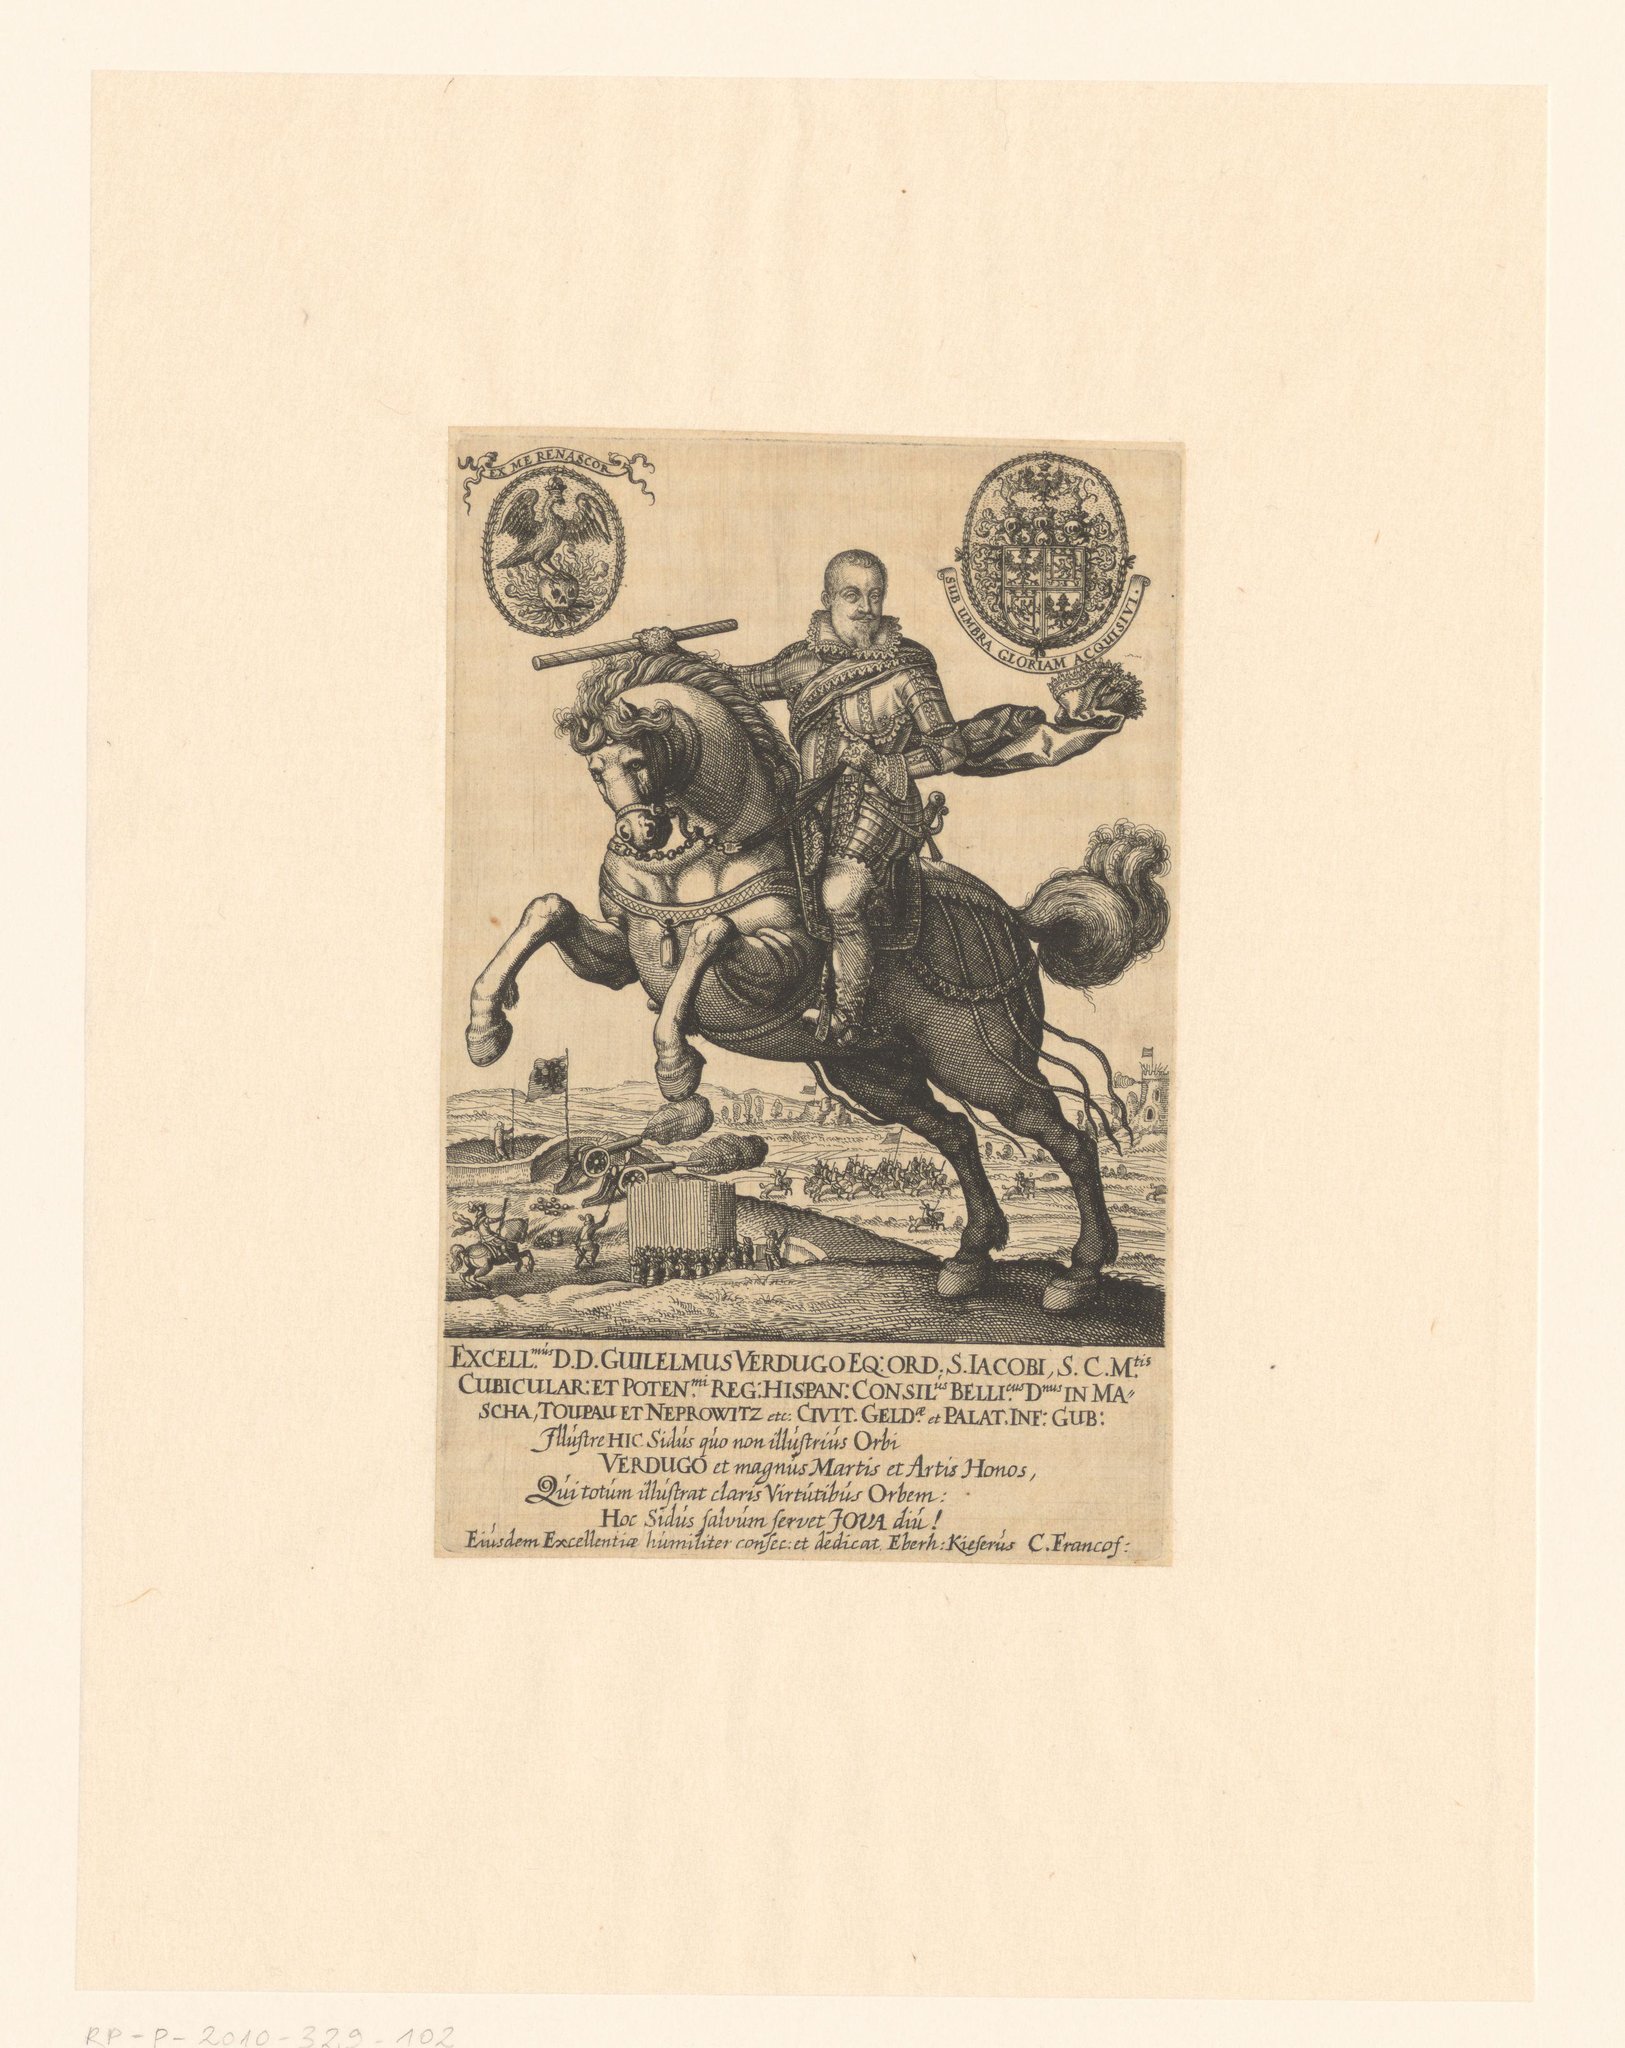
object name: print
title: Portret van Wilhelm von Verdugo te paard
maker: eberhard kieser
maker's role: print maker, publisher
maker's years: 1583-1631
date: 1593-1625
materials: paper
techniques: engraving, etching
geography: frankfurt am main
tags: commander-in-chief, general, marshal, historical persons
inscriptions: collector's mark: Lugt 2228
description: Bovenaan een wapenschild en embleem, in de marge onderaan tekst in het Latijn.